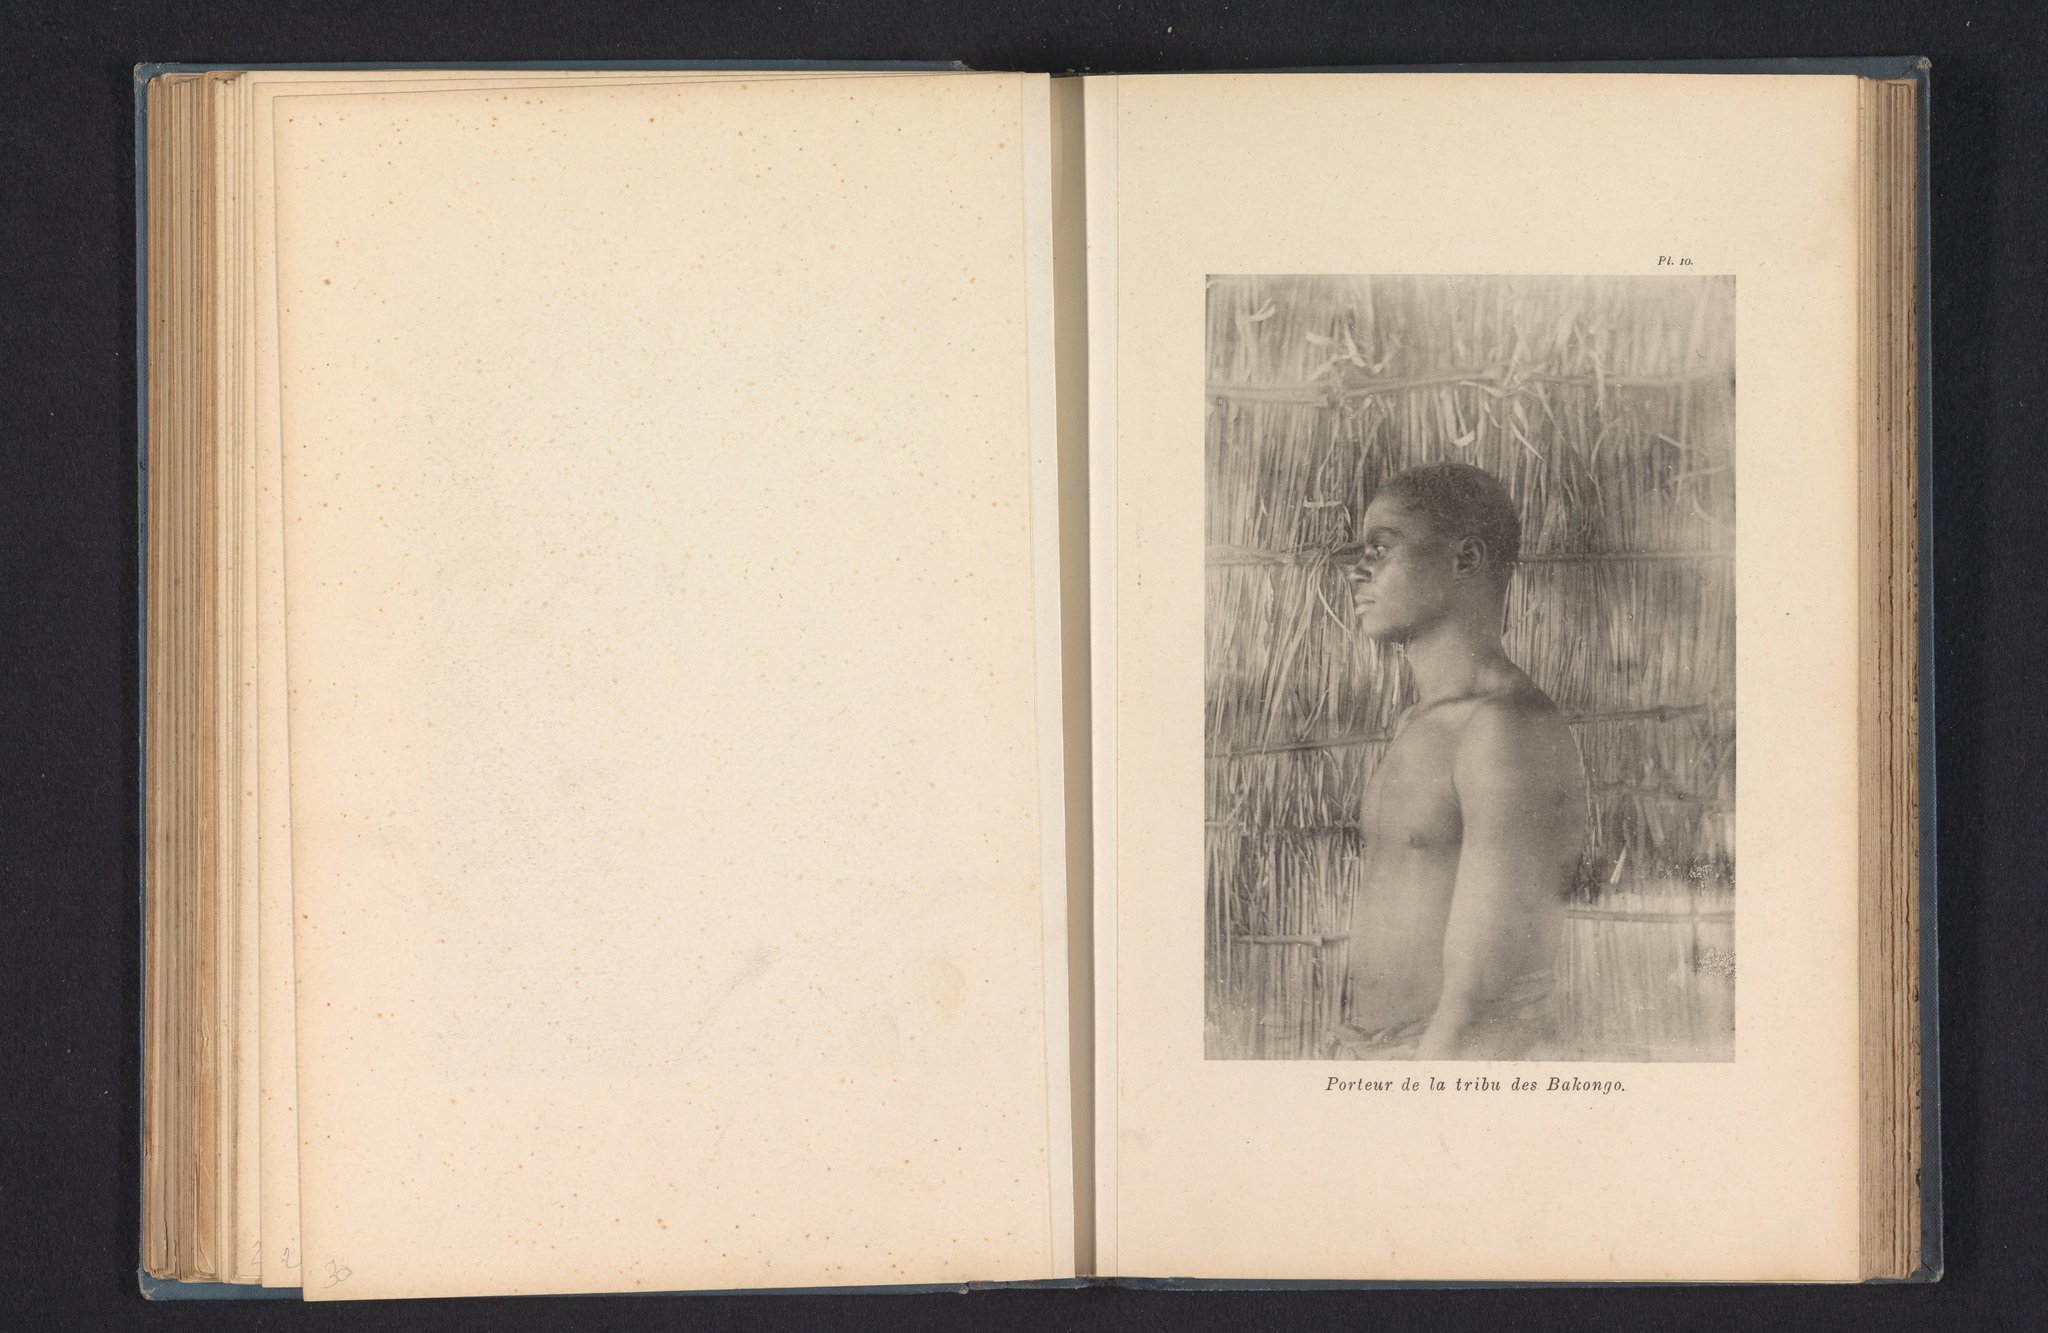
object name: photomechanical print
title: Porteur de la tribu des Bakongo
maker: franz thonner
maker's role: botanicus, ontdekkingsreiziger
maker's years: 1863-1928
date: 1896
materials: paper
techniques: photograph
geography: dresden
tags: porter, bearer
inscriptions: number: ‘Pl. 10.’